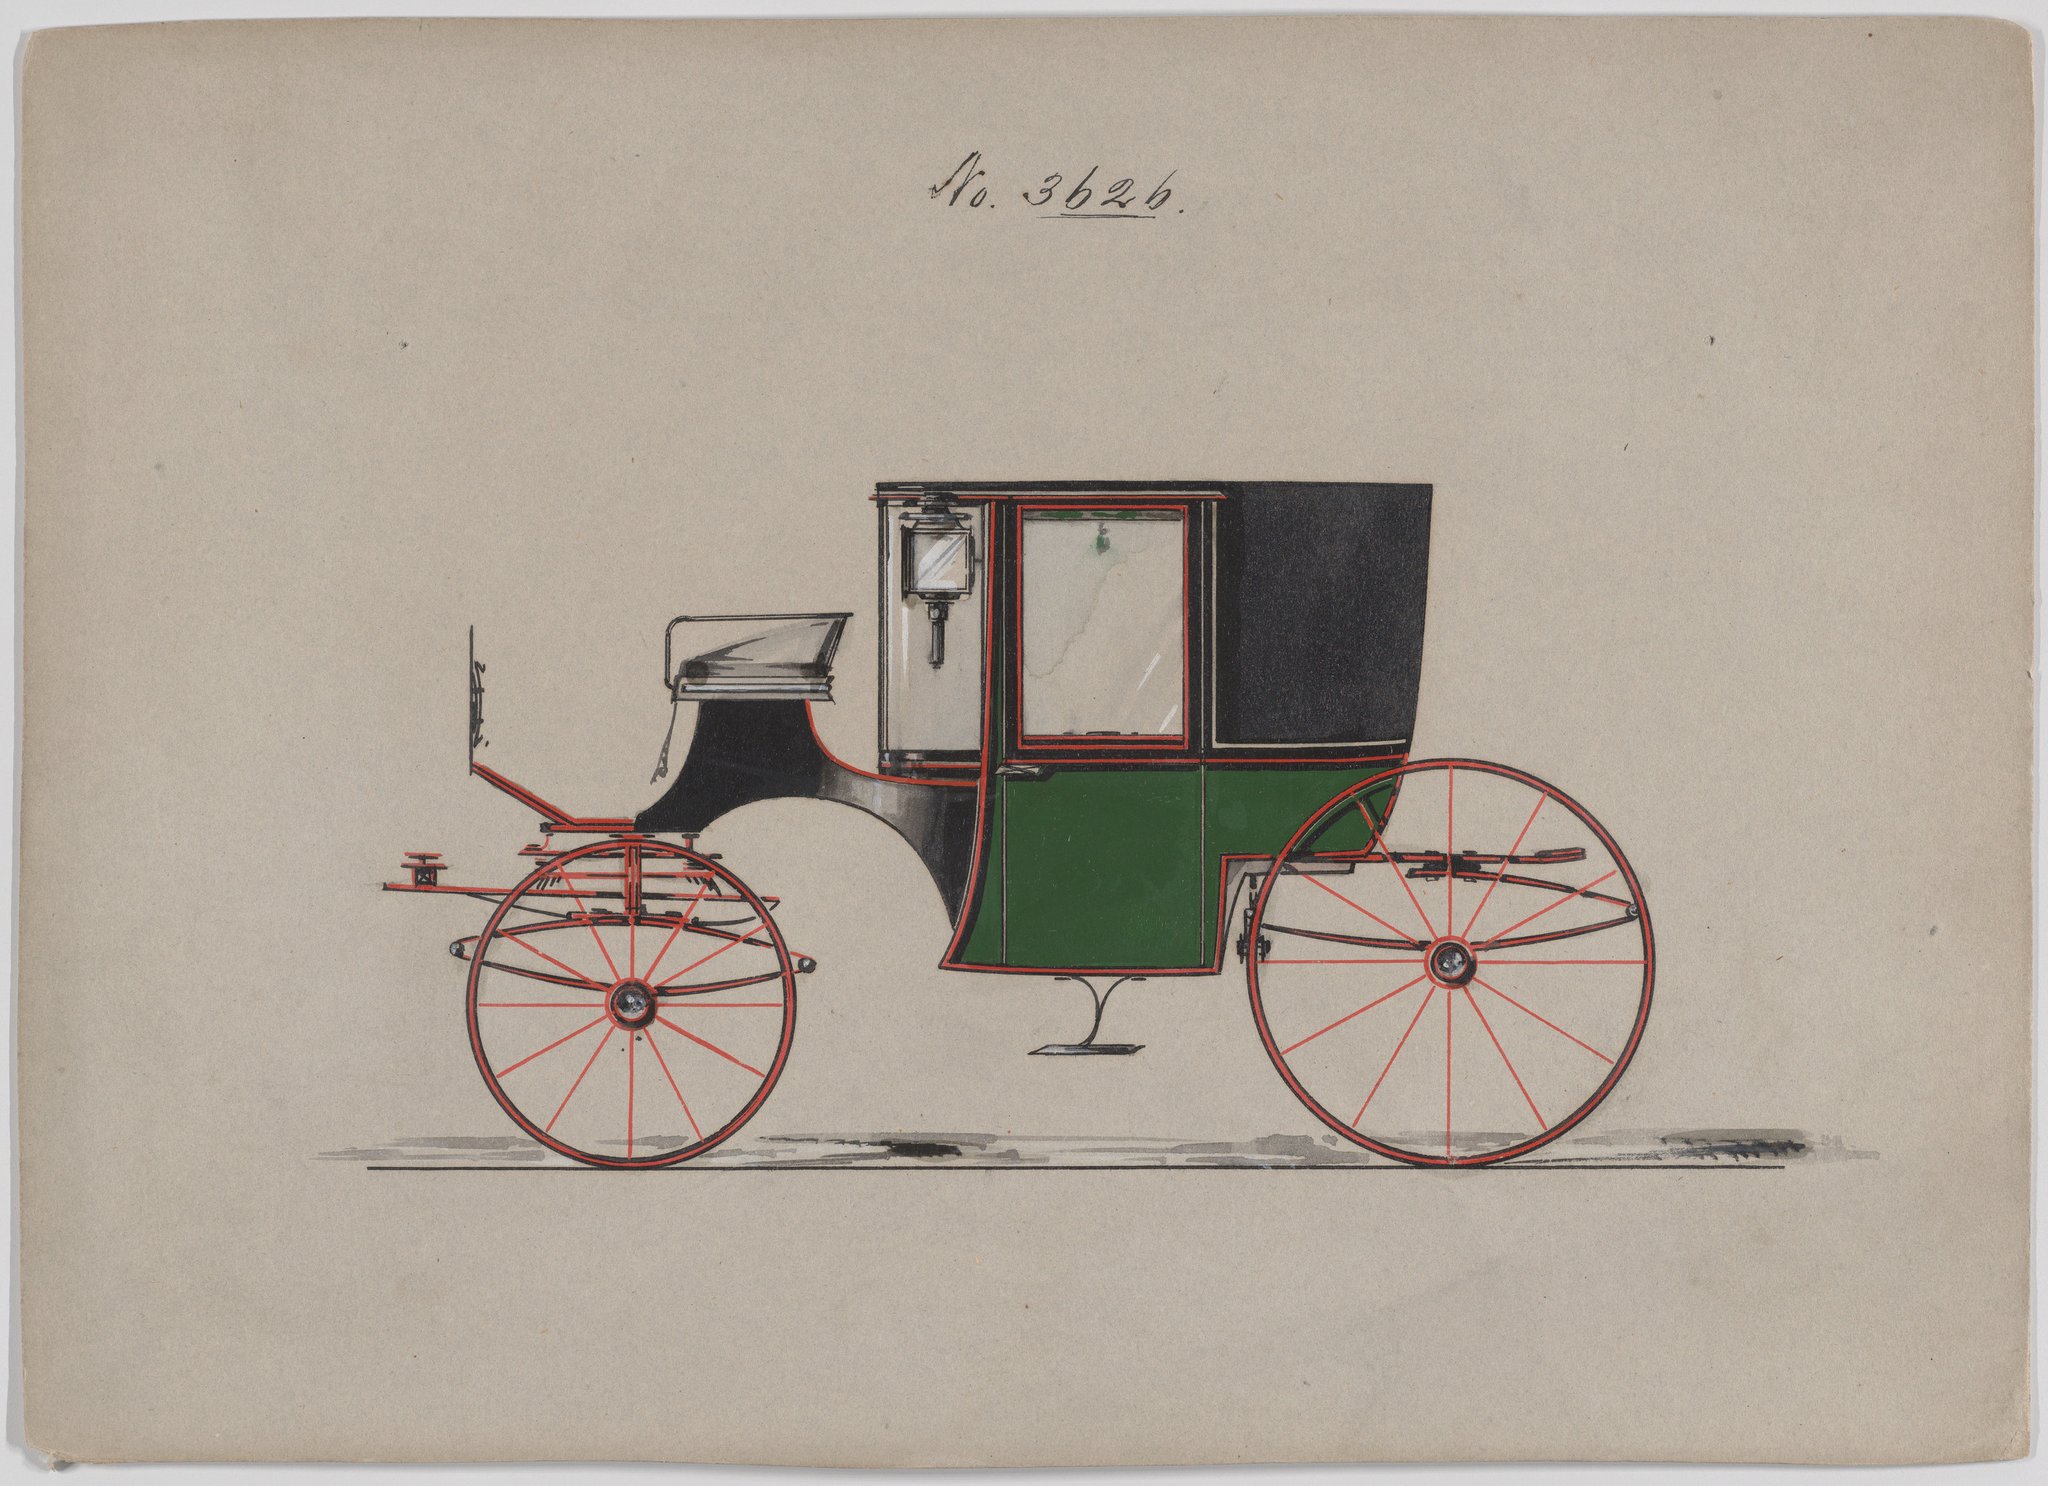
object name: drawing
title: Design for Coupé, no. 3625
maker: brewster & co.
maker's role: manufacturer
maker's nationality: american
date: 1880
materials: gouache, gum arabic, ink, watercolor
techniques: pen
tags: carriages